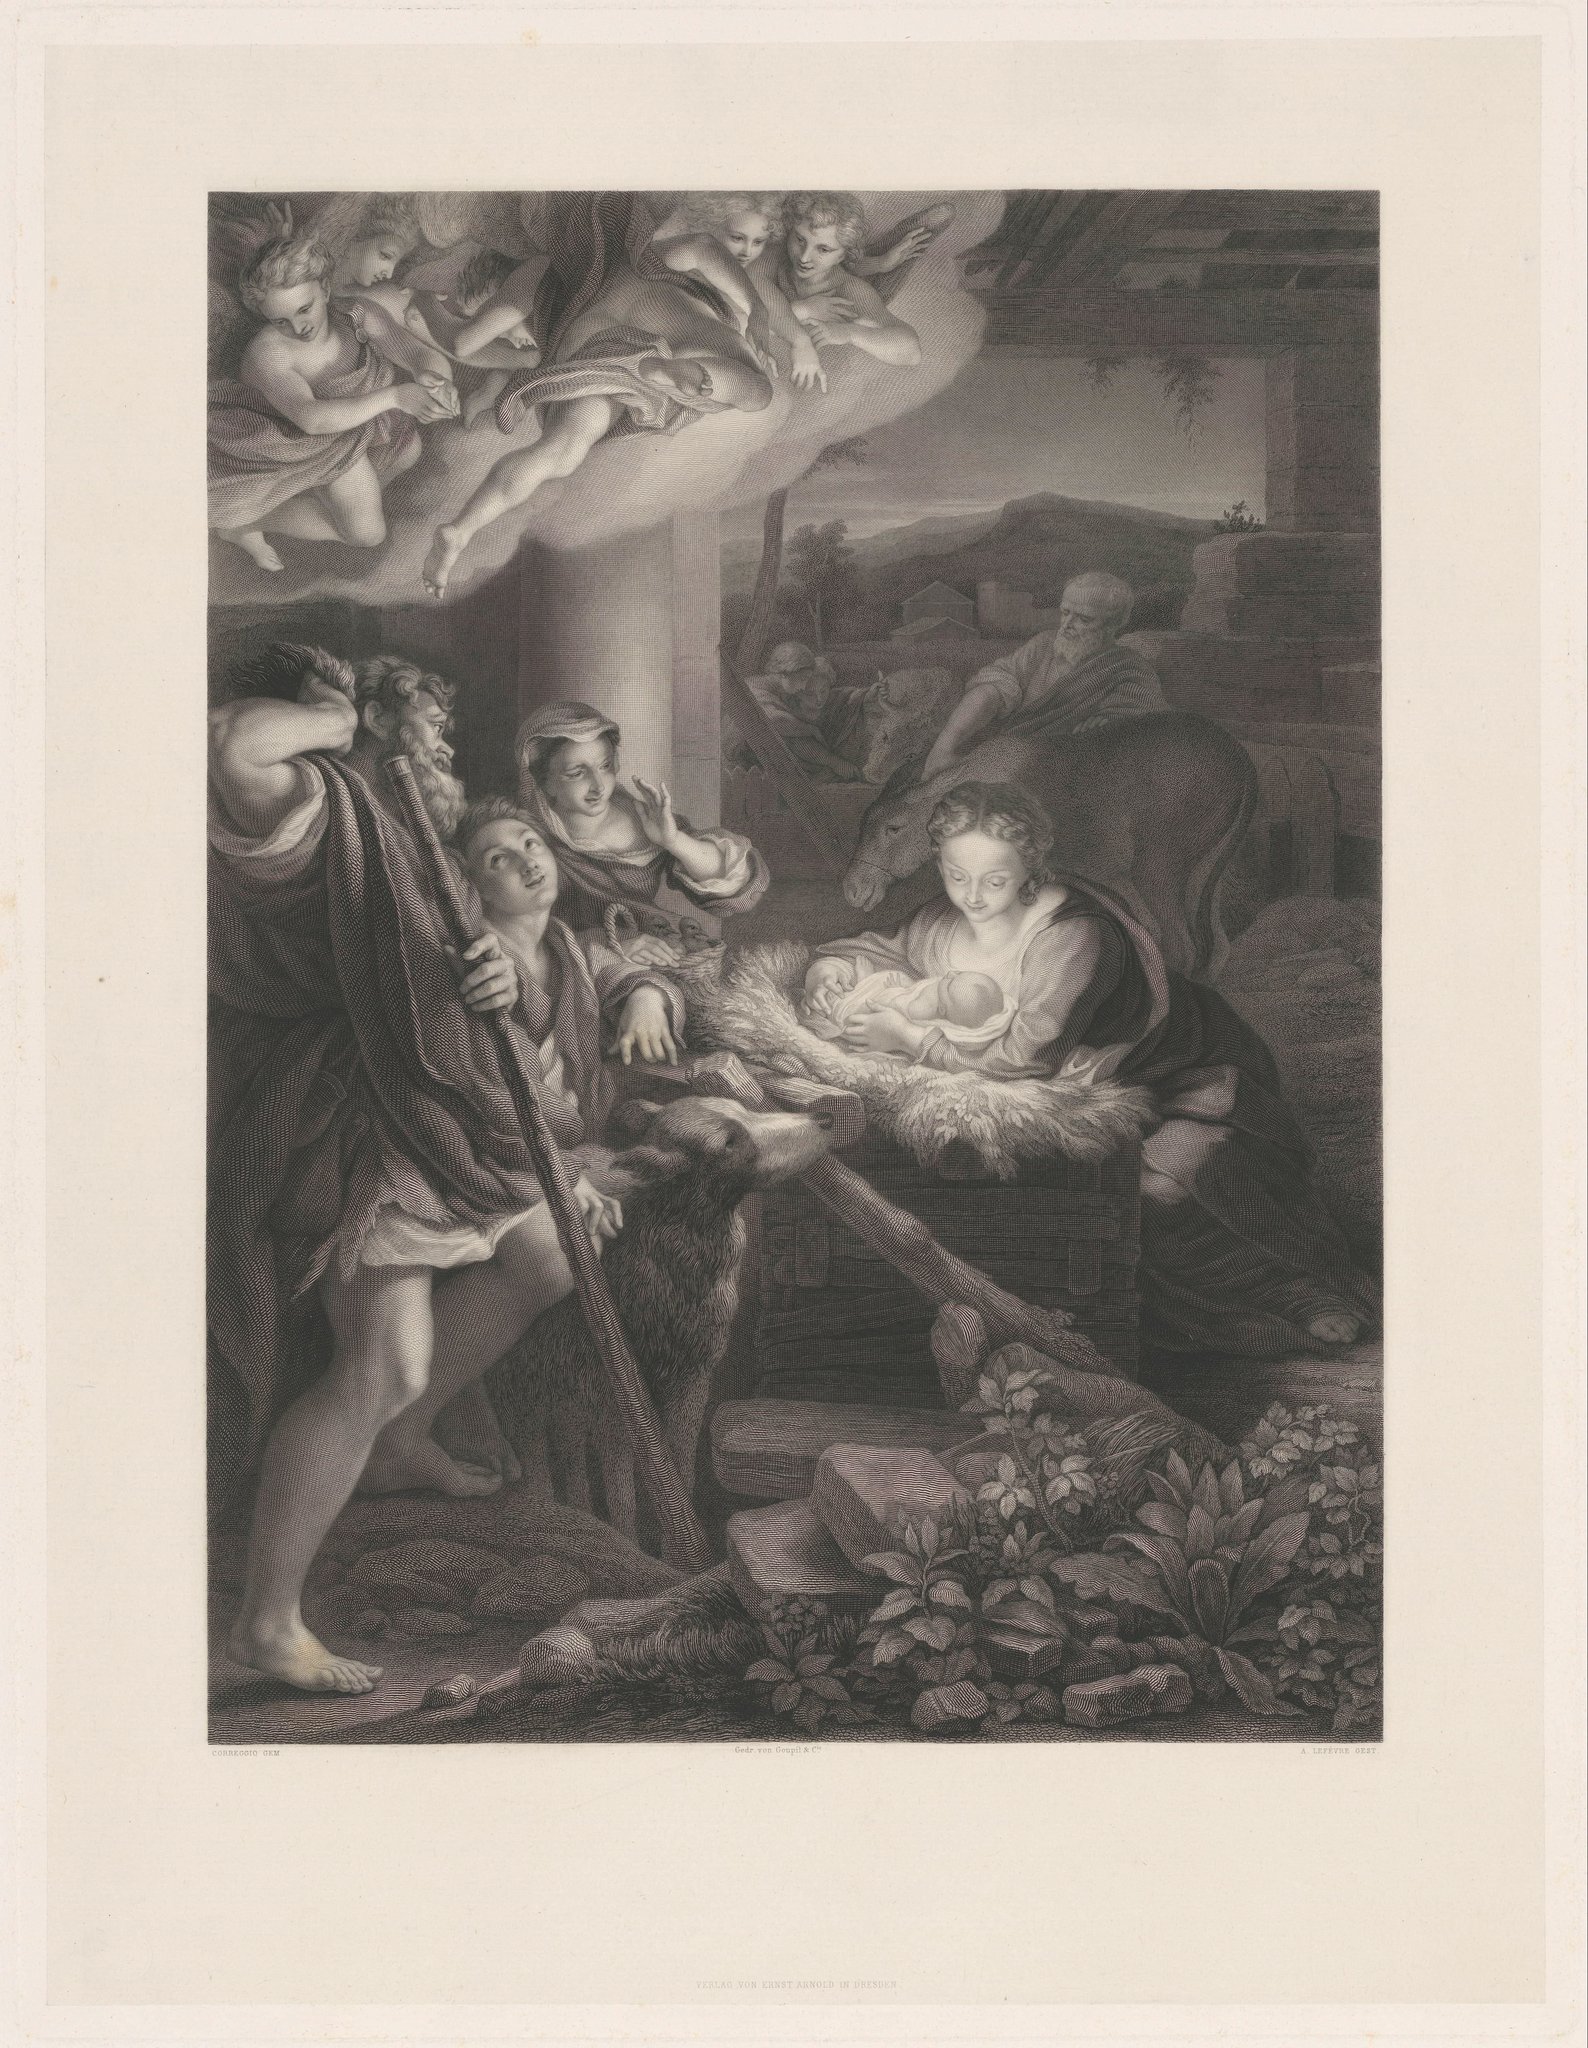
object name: print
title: Geboorte van Christus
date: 1815-1840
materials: paper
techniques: engraving, etching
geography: paris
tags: birth and youth of christ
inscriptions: collector's mark: Lugt 12